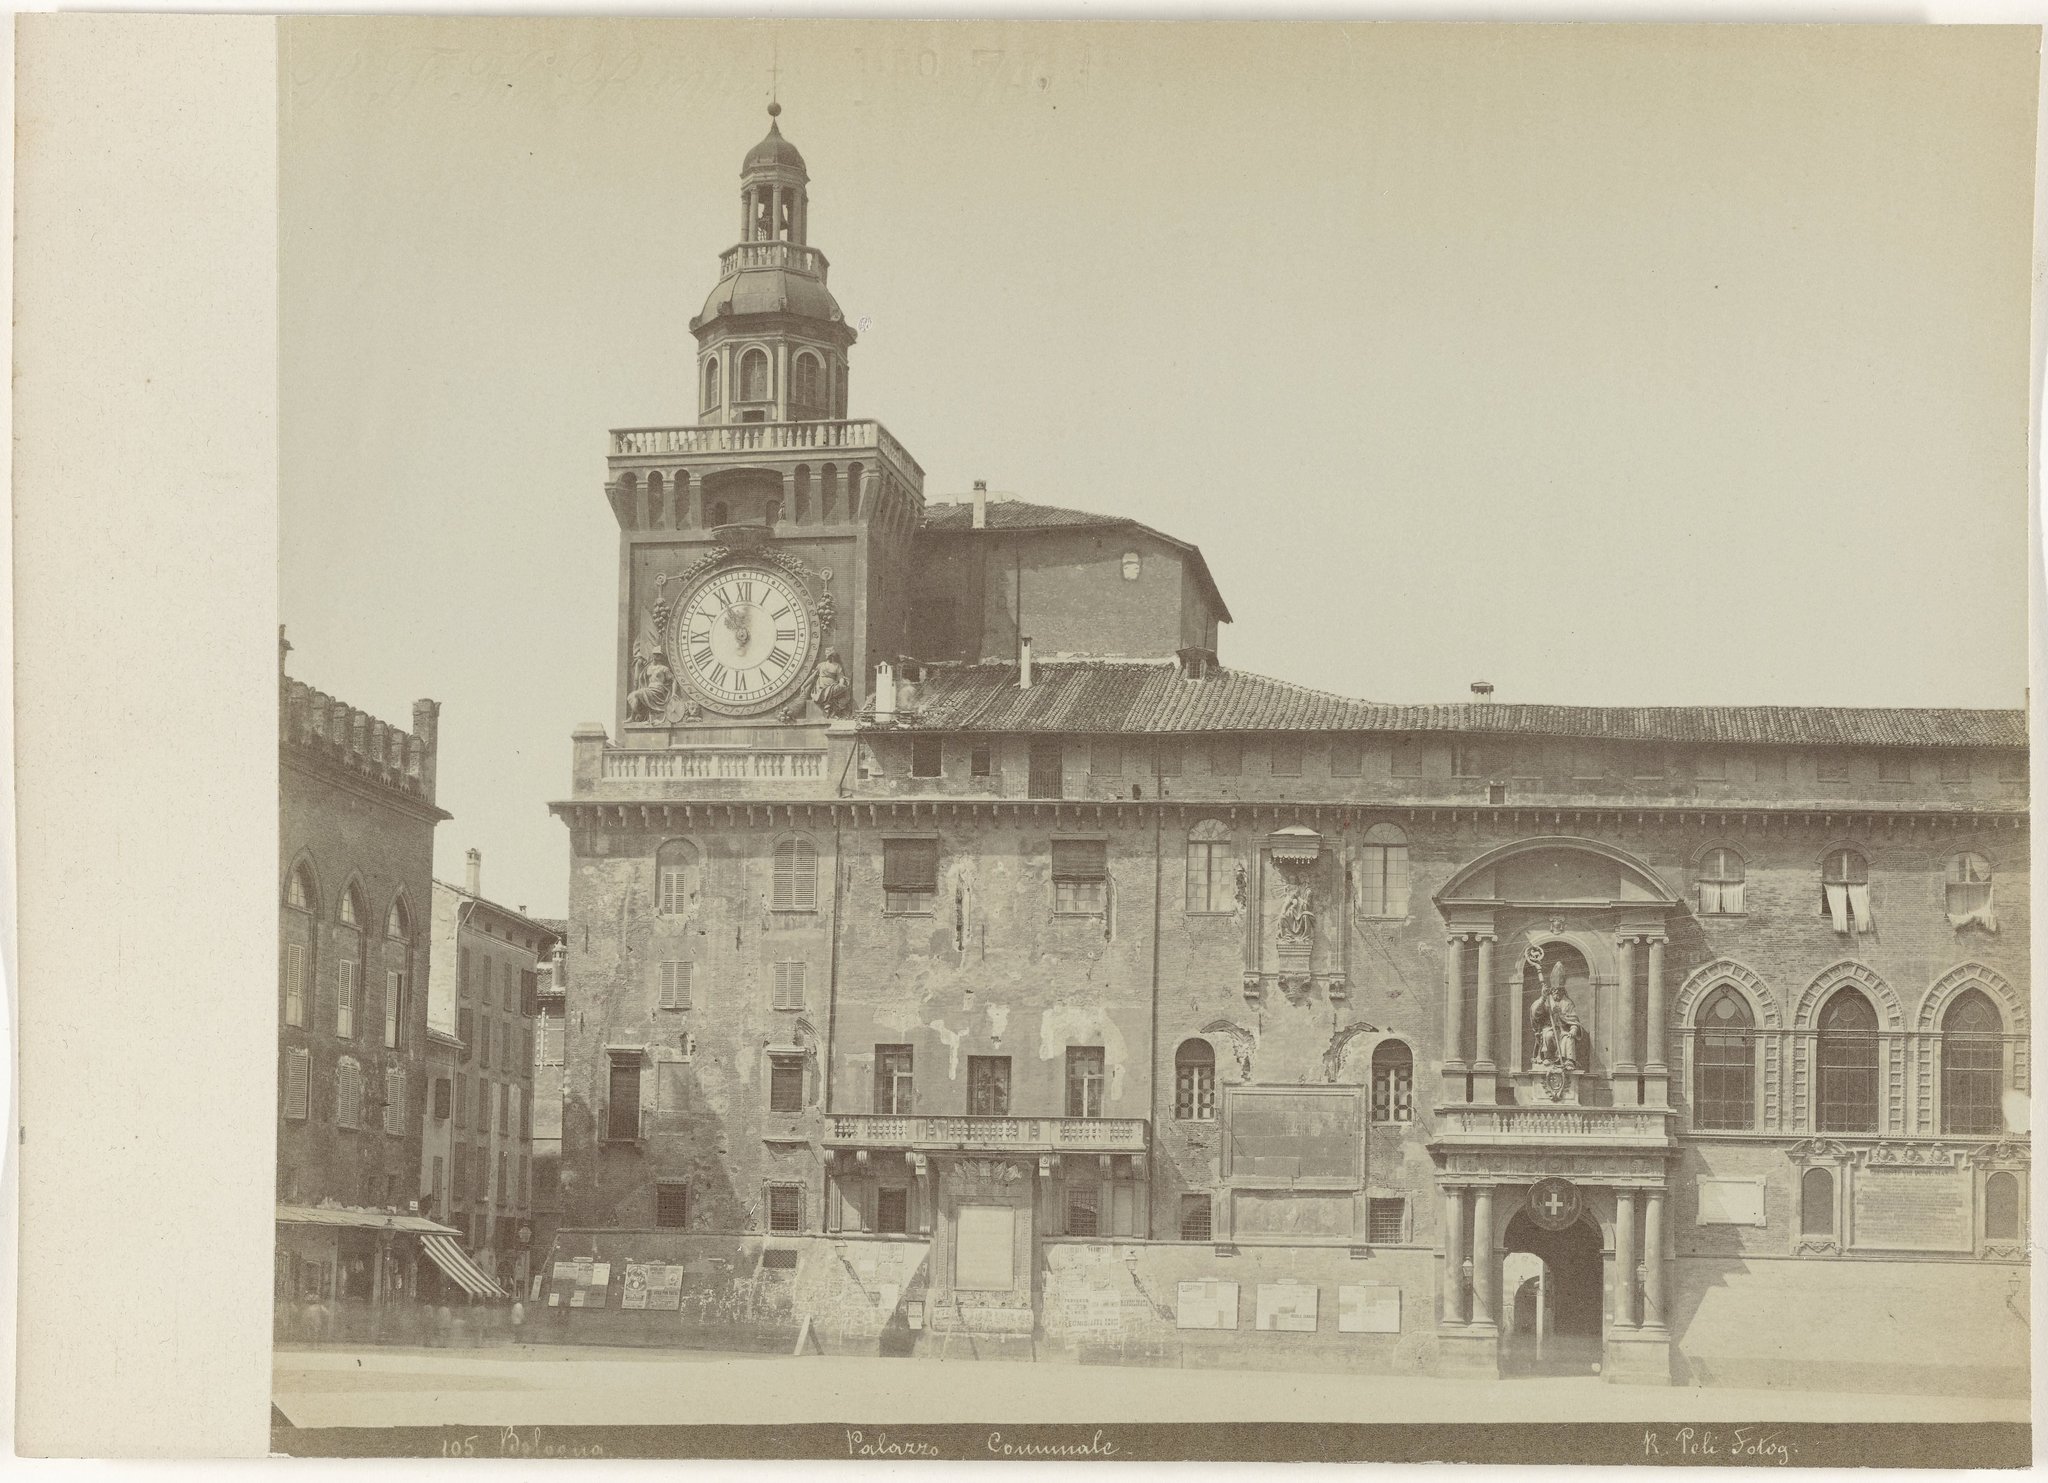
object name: photograph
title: Gezicht op het Palazzo Communale in Bologna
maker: r. peli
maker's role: fotograaf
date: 1870-1890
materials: cardboard, paper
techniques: albumen print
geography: bologna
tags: palace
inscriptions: annotation: ‘105 Bologna Palazzo Communale R. Peli. Fot.’